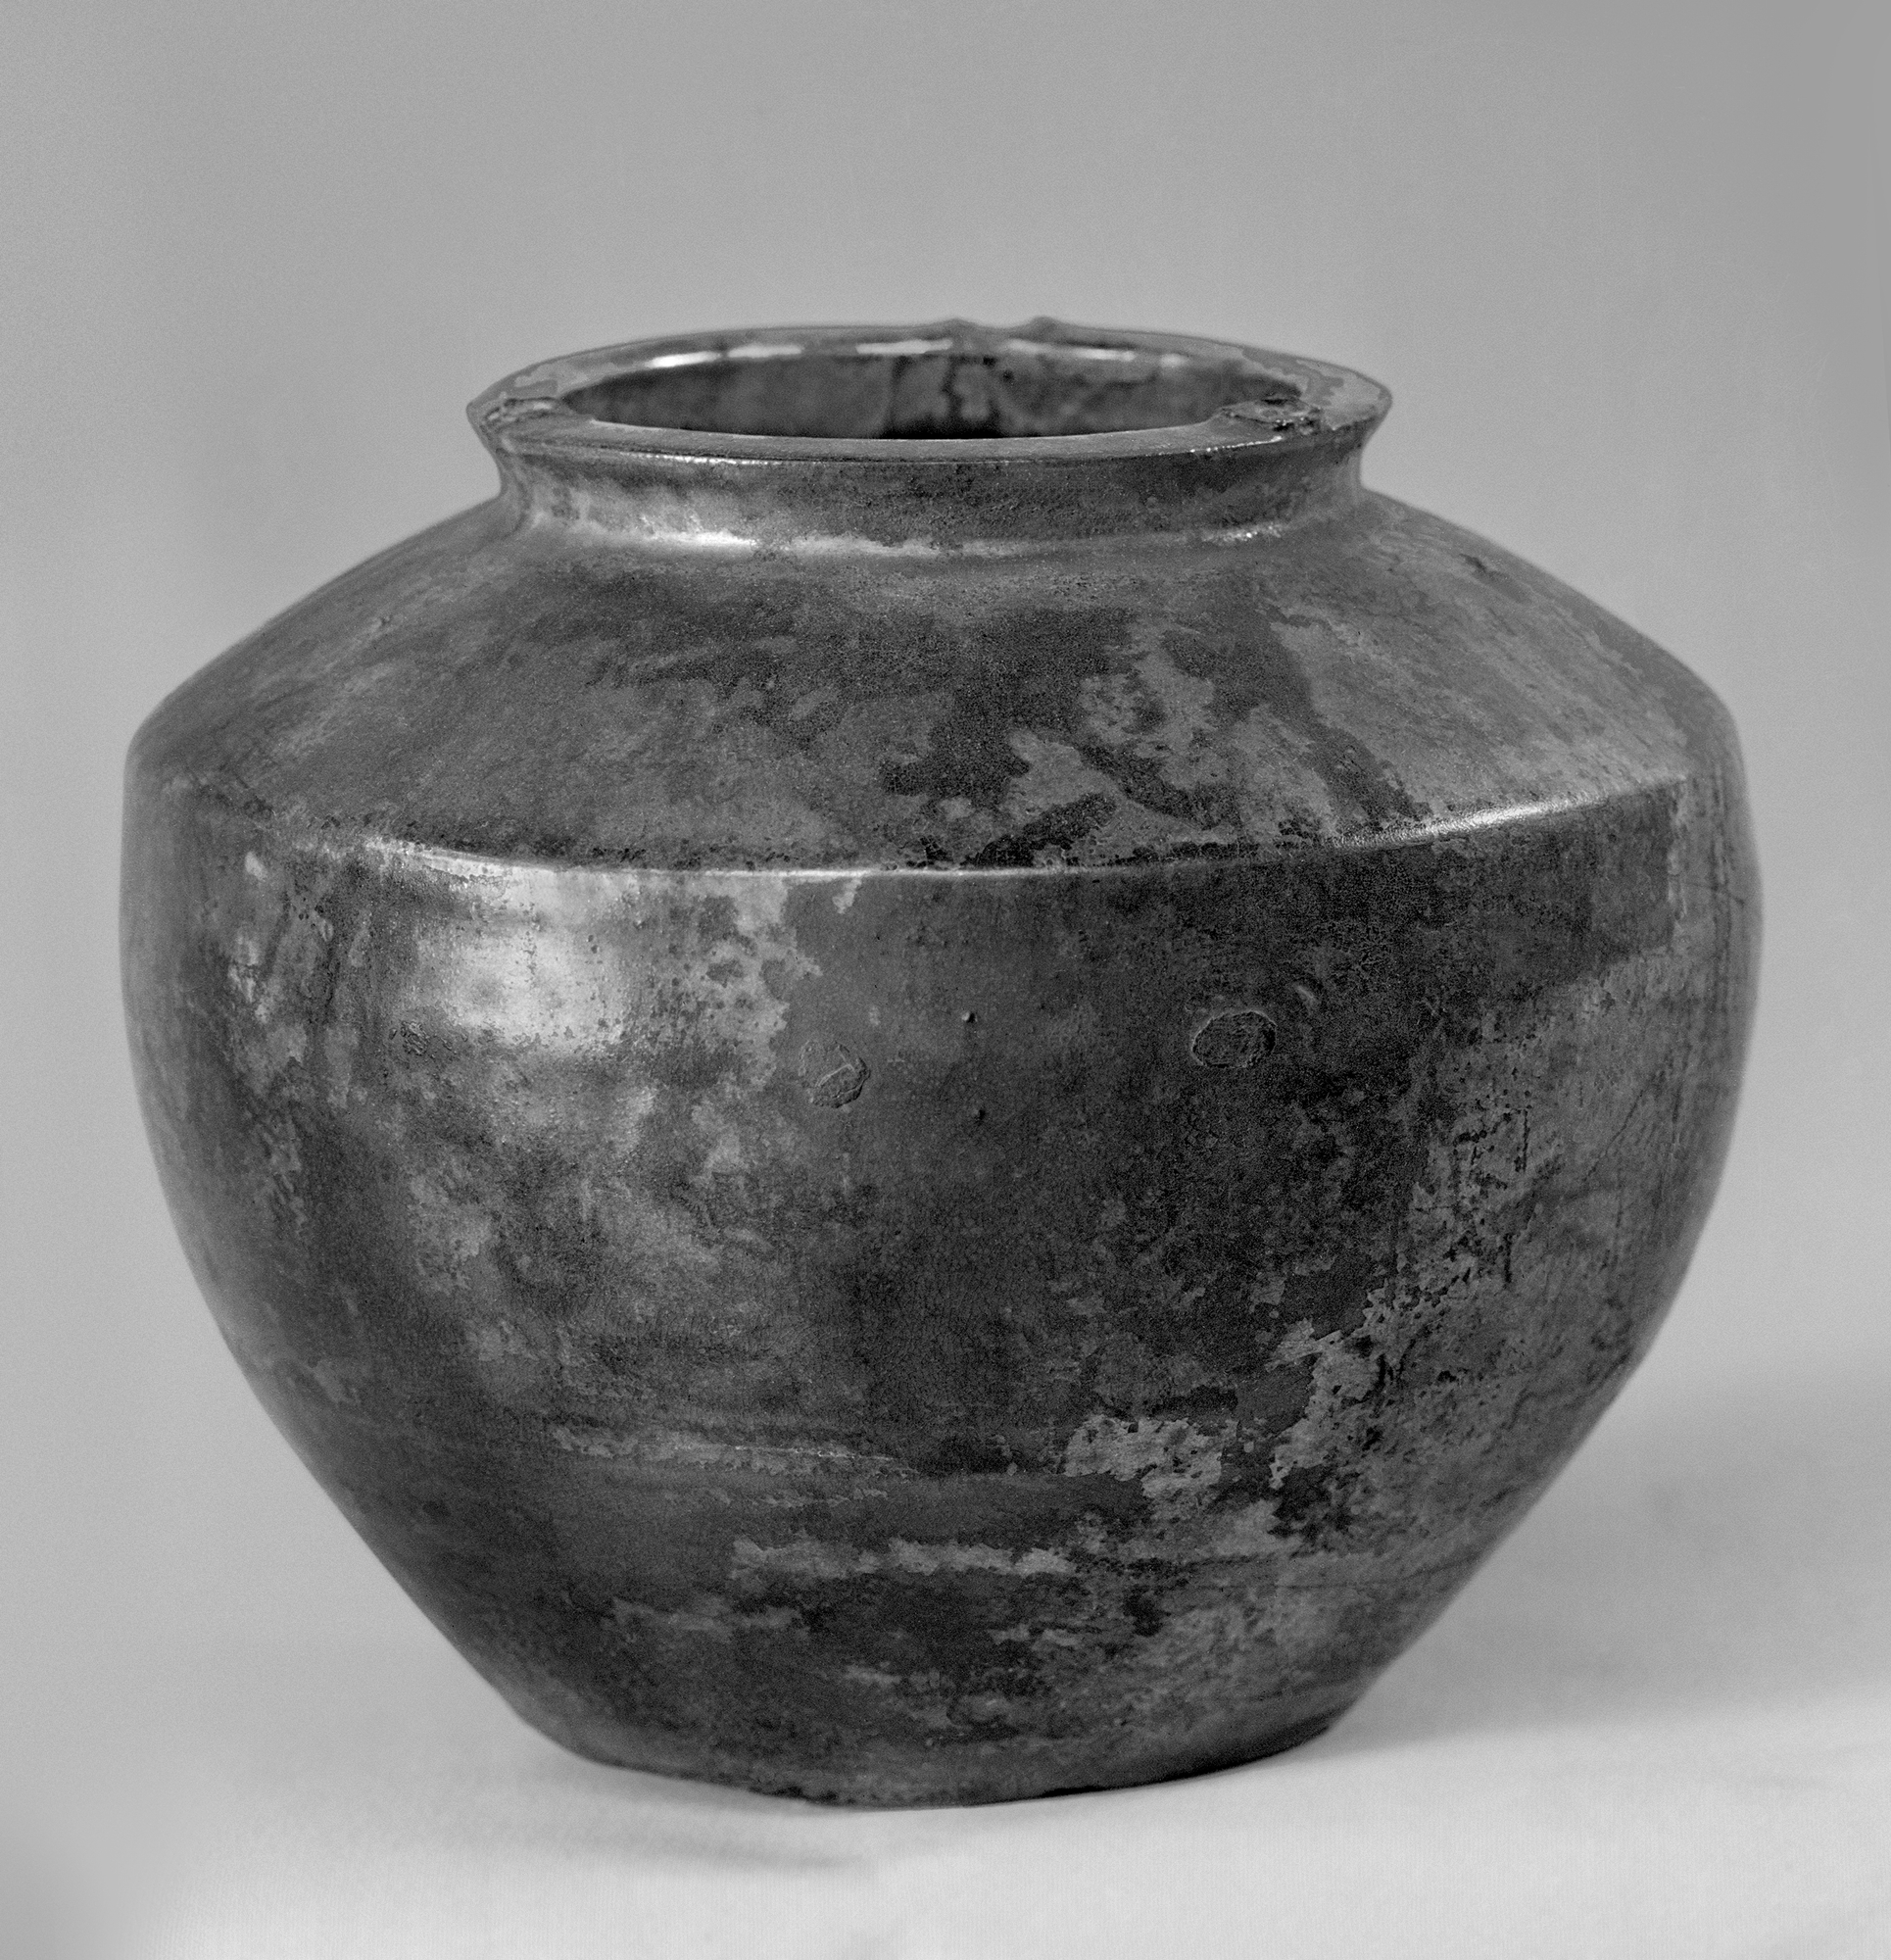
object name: jar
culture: chinese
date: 206 BCE-220 CE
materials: pottery